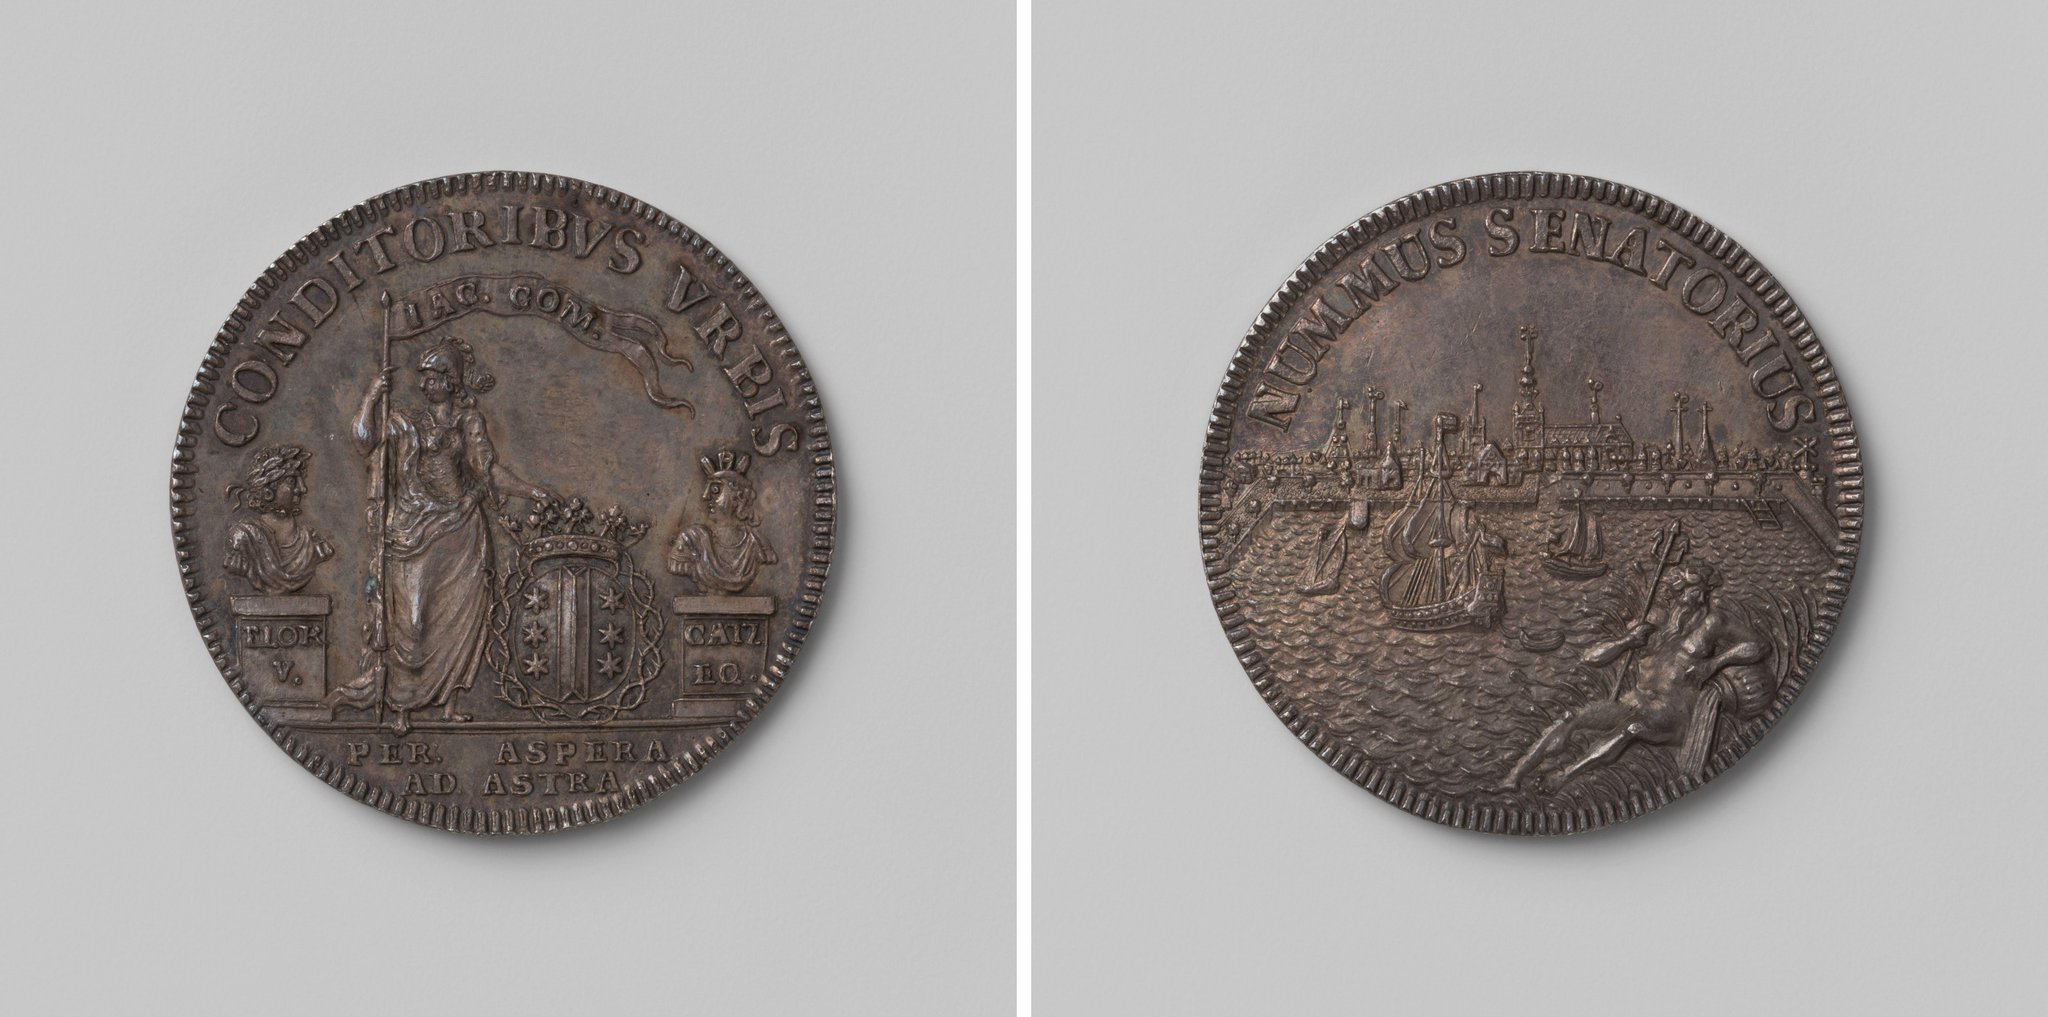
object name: council medal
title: Vroedschapspenning van de stad Gouda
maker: Anonymous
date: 1706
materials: silver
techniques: striking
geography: dordrecht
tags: leiden, floris v (graaf van holland en zeeland), jacoba of bavaria (countess of hainaut), gouda